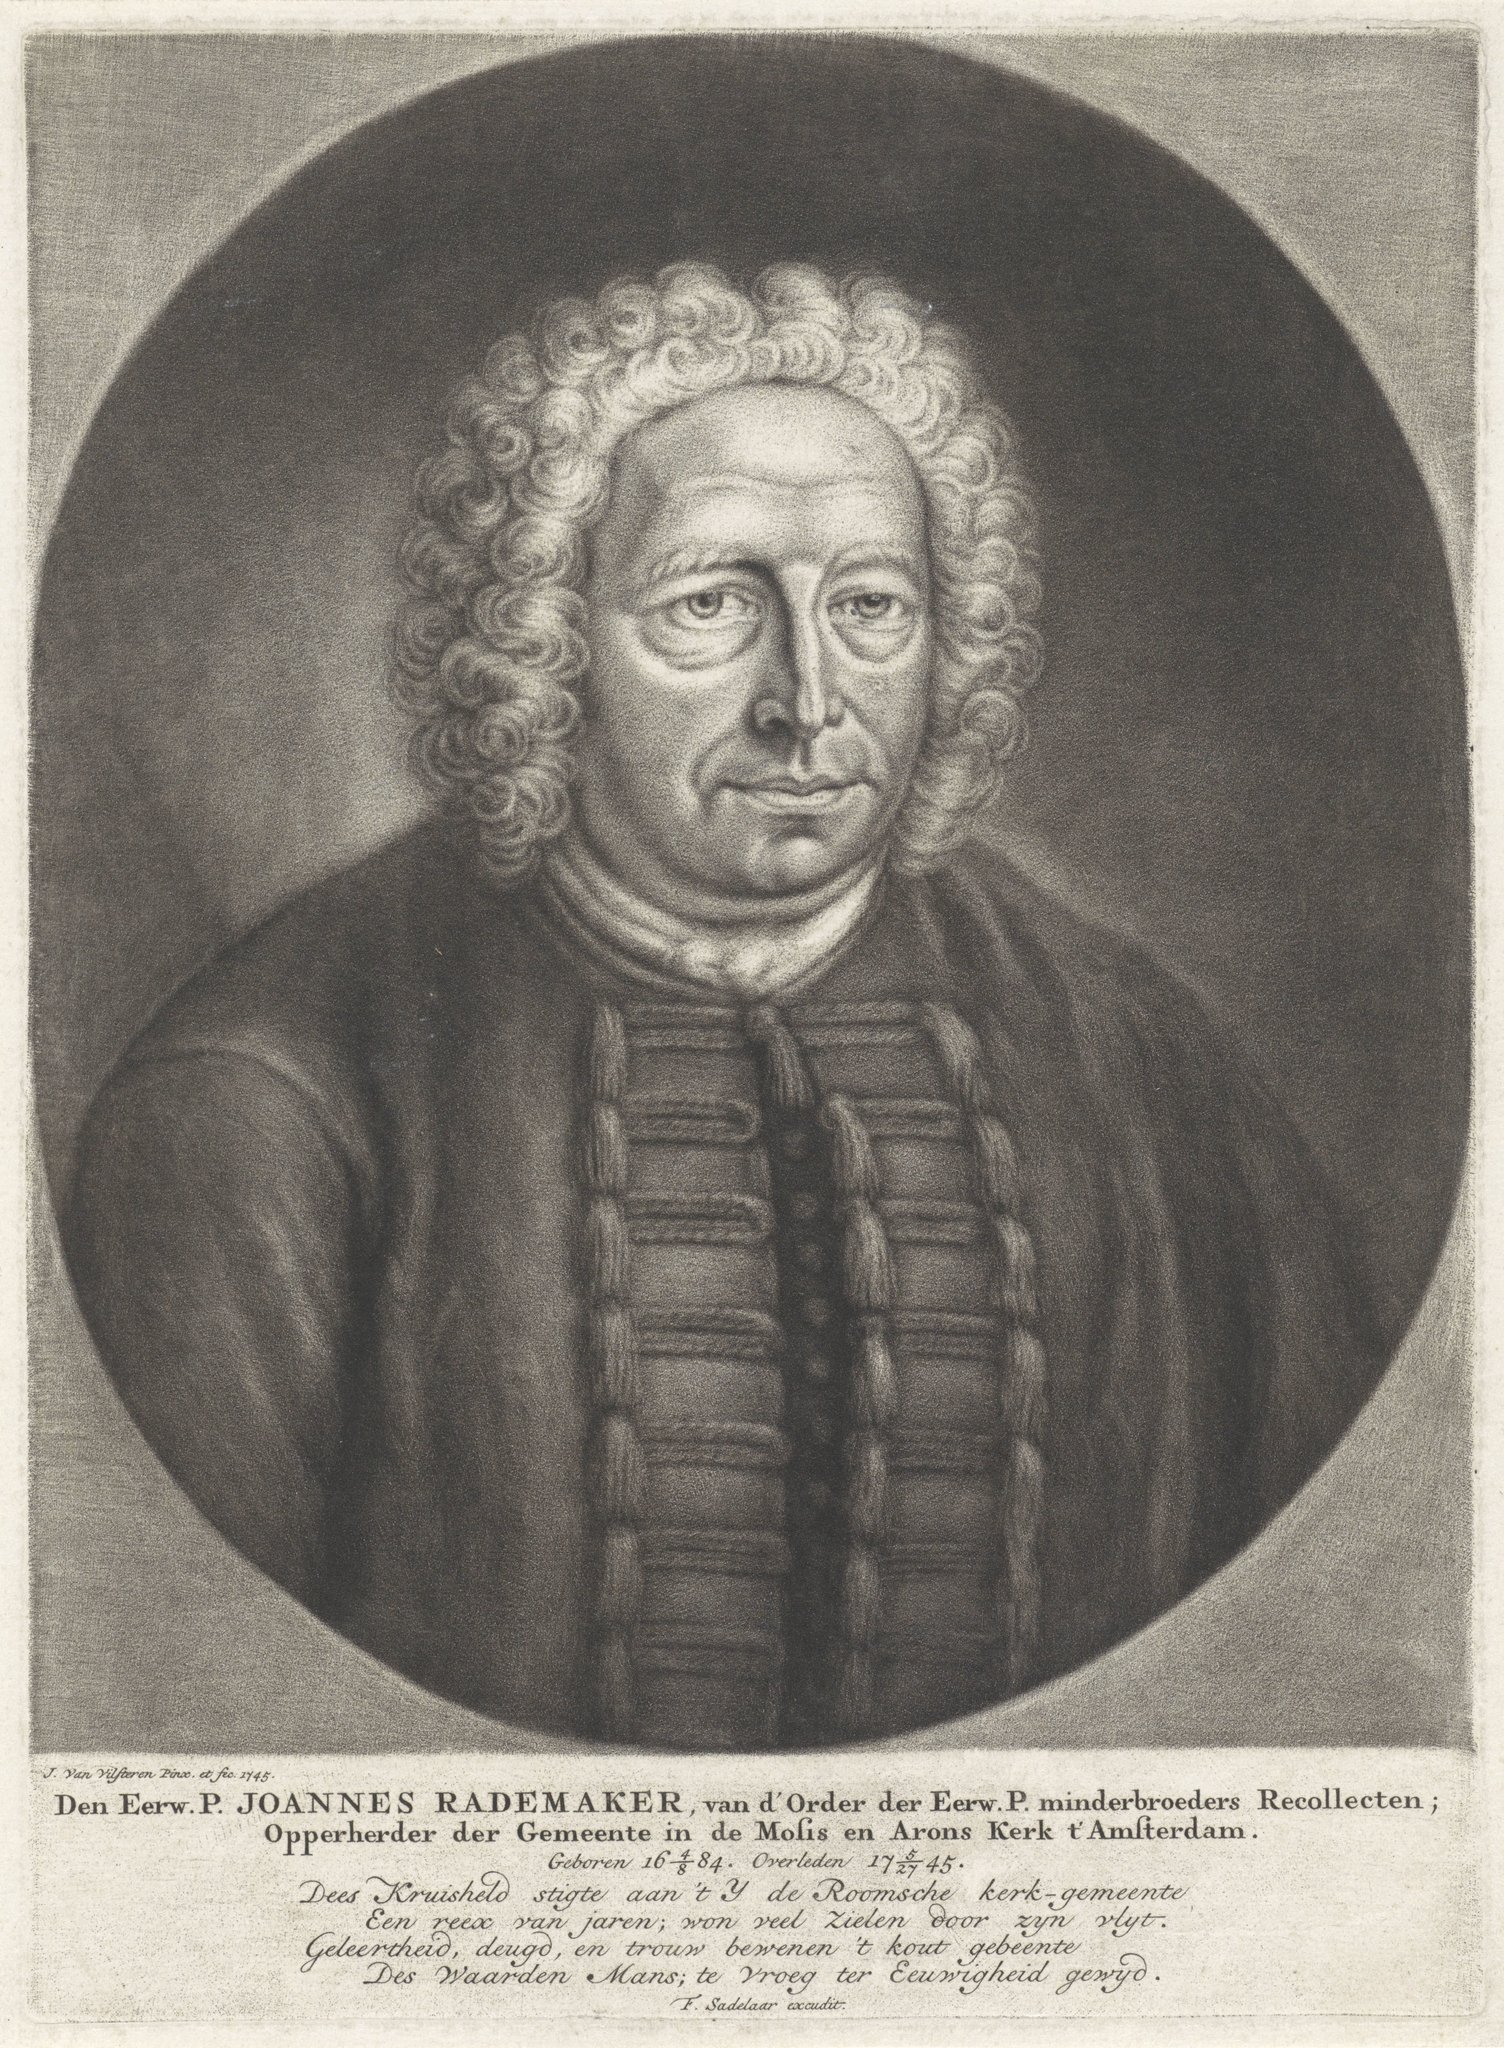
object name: print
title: Portret van de pastoor Johannes Rademaker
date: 1745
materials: paper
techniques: engraving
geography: amsterdam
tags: pastoor, johannes rademaker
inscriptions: collector's mark: Lugt 2228